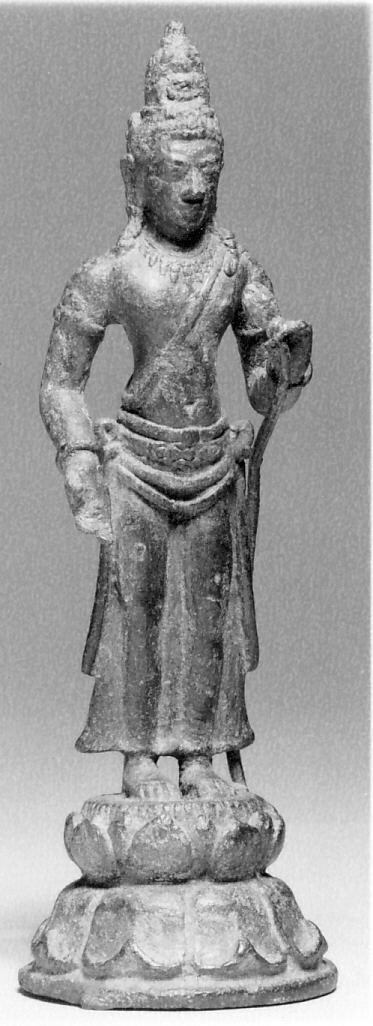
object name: figure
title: Standing Bodhisattva on Tall Base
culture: indonesian, javanese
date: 801-900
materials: bronze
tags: buddhism,bodhisattvas